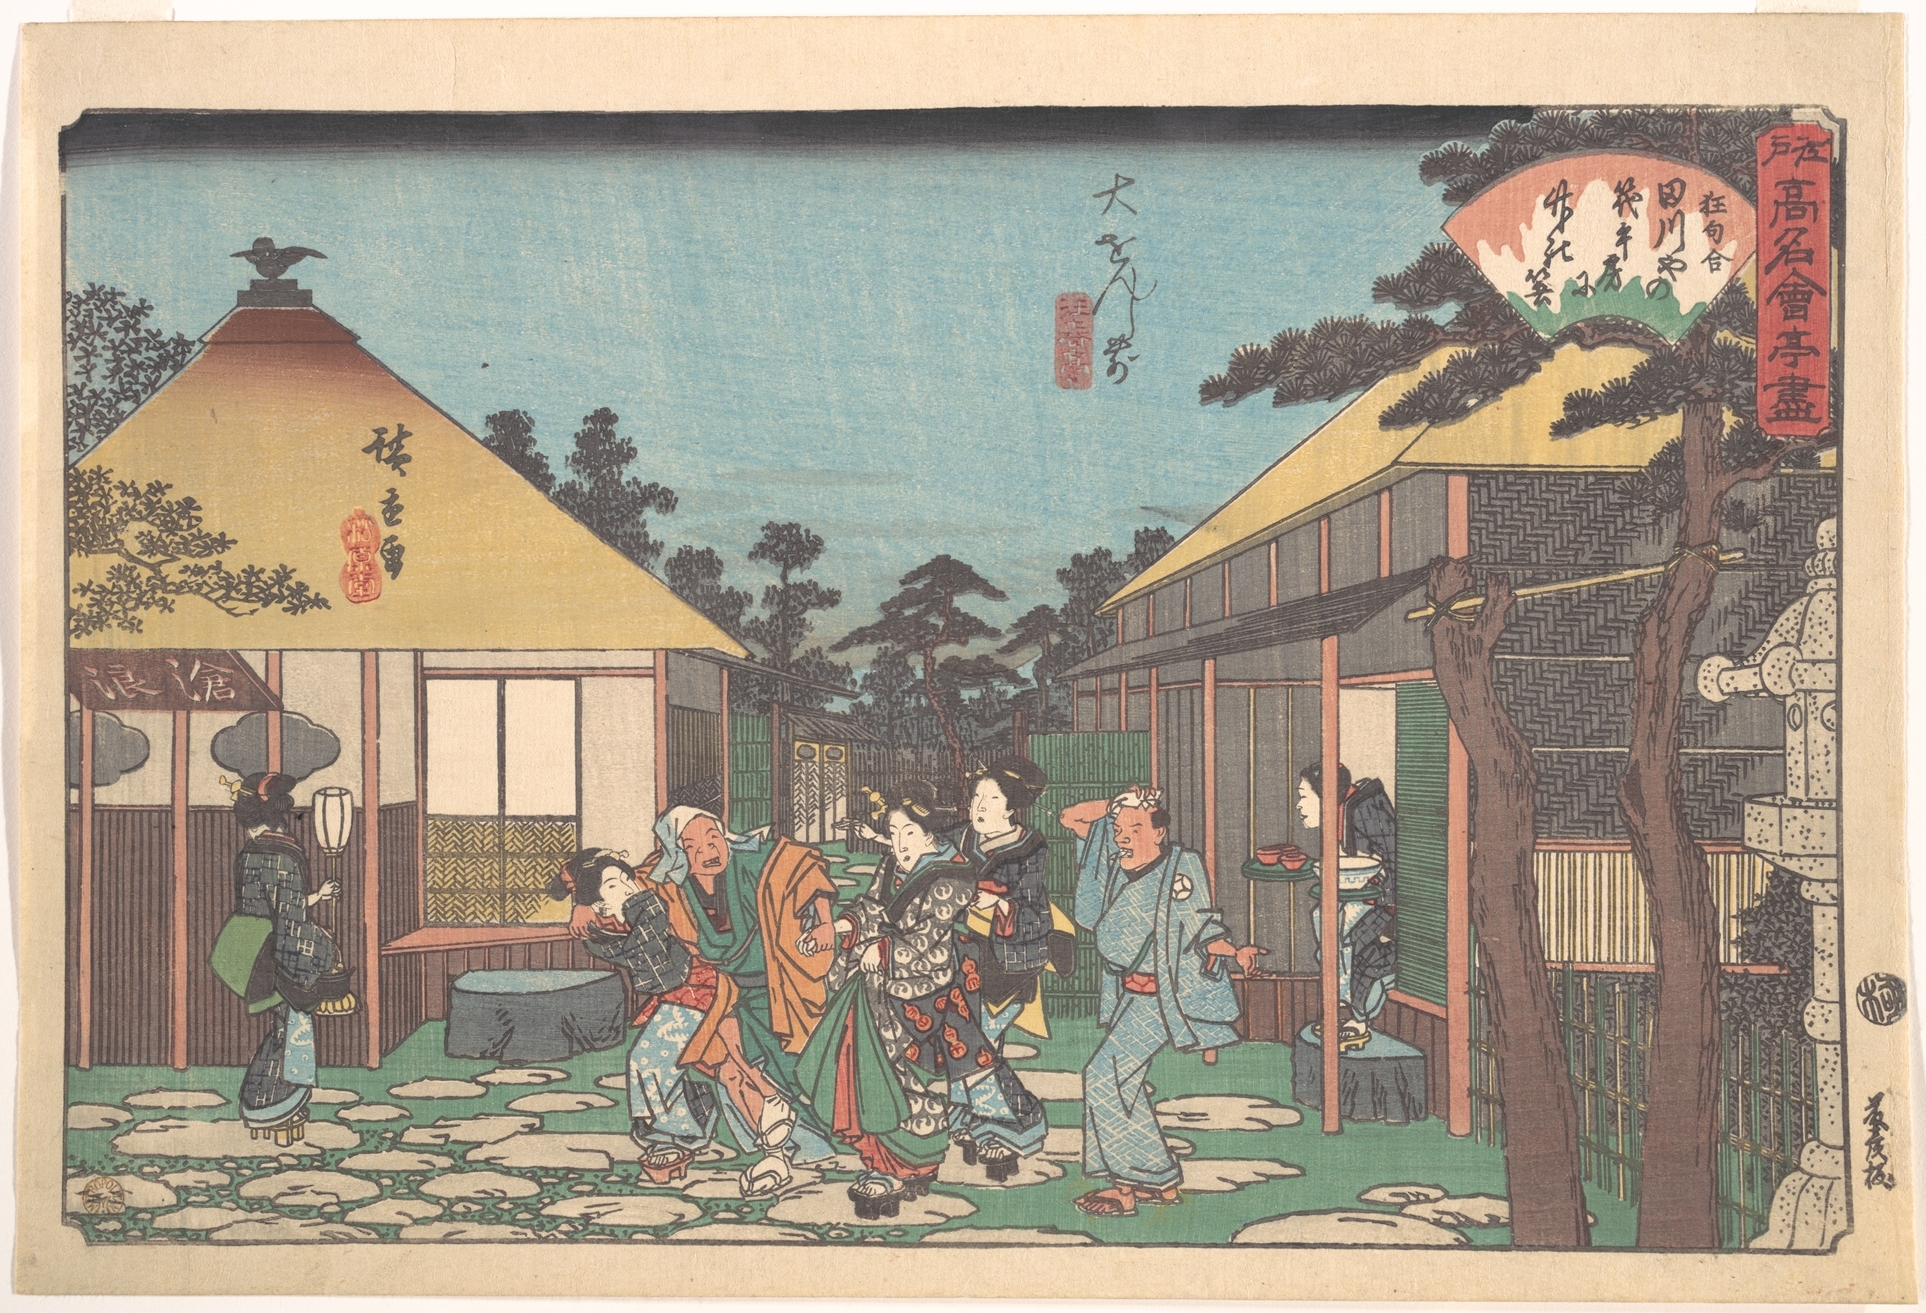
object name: print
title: Daisenji Mae (Tagawaya)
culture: japanese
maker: utagawa hiroshige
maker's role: artist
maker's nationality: japanese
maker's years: 1797-1858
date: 1835-1842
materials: ink, paper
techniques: woodblock print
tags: men,women,tea houses